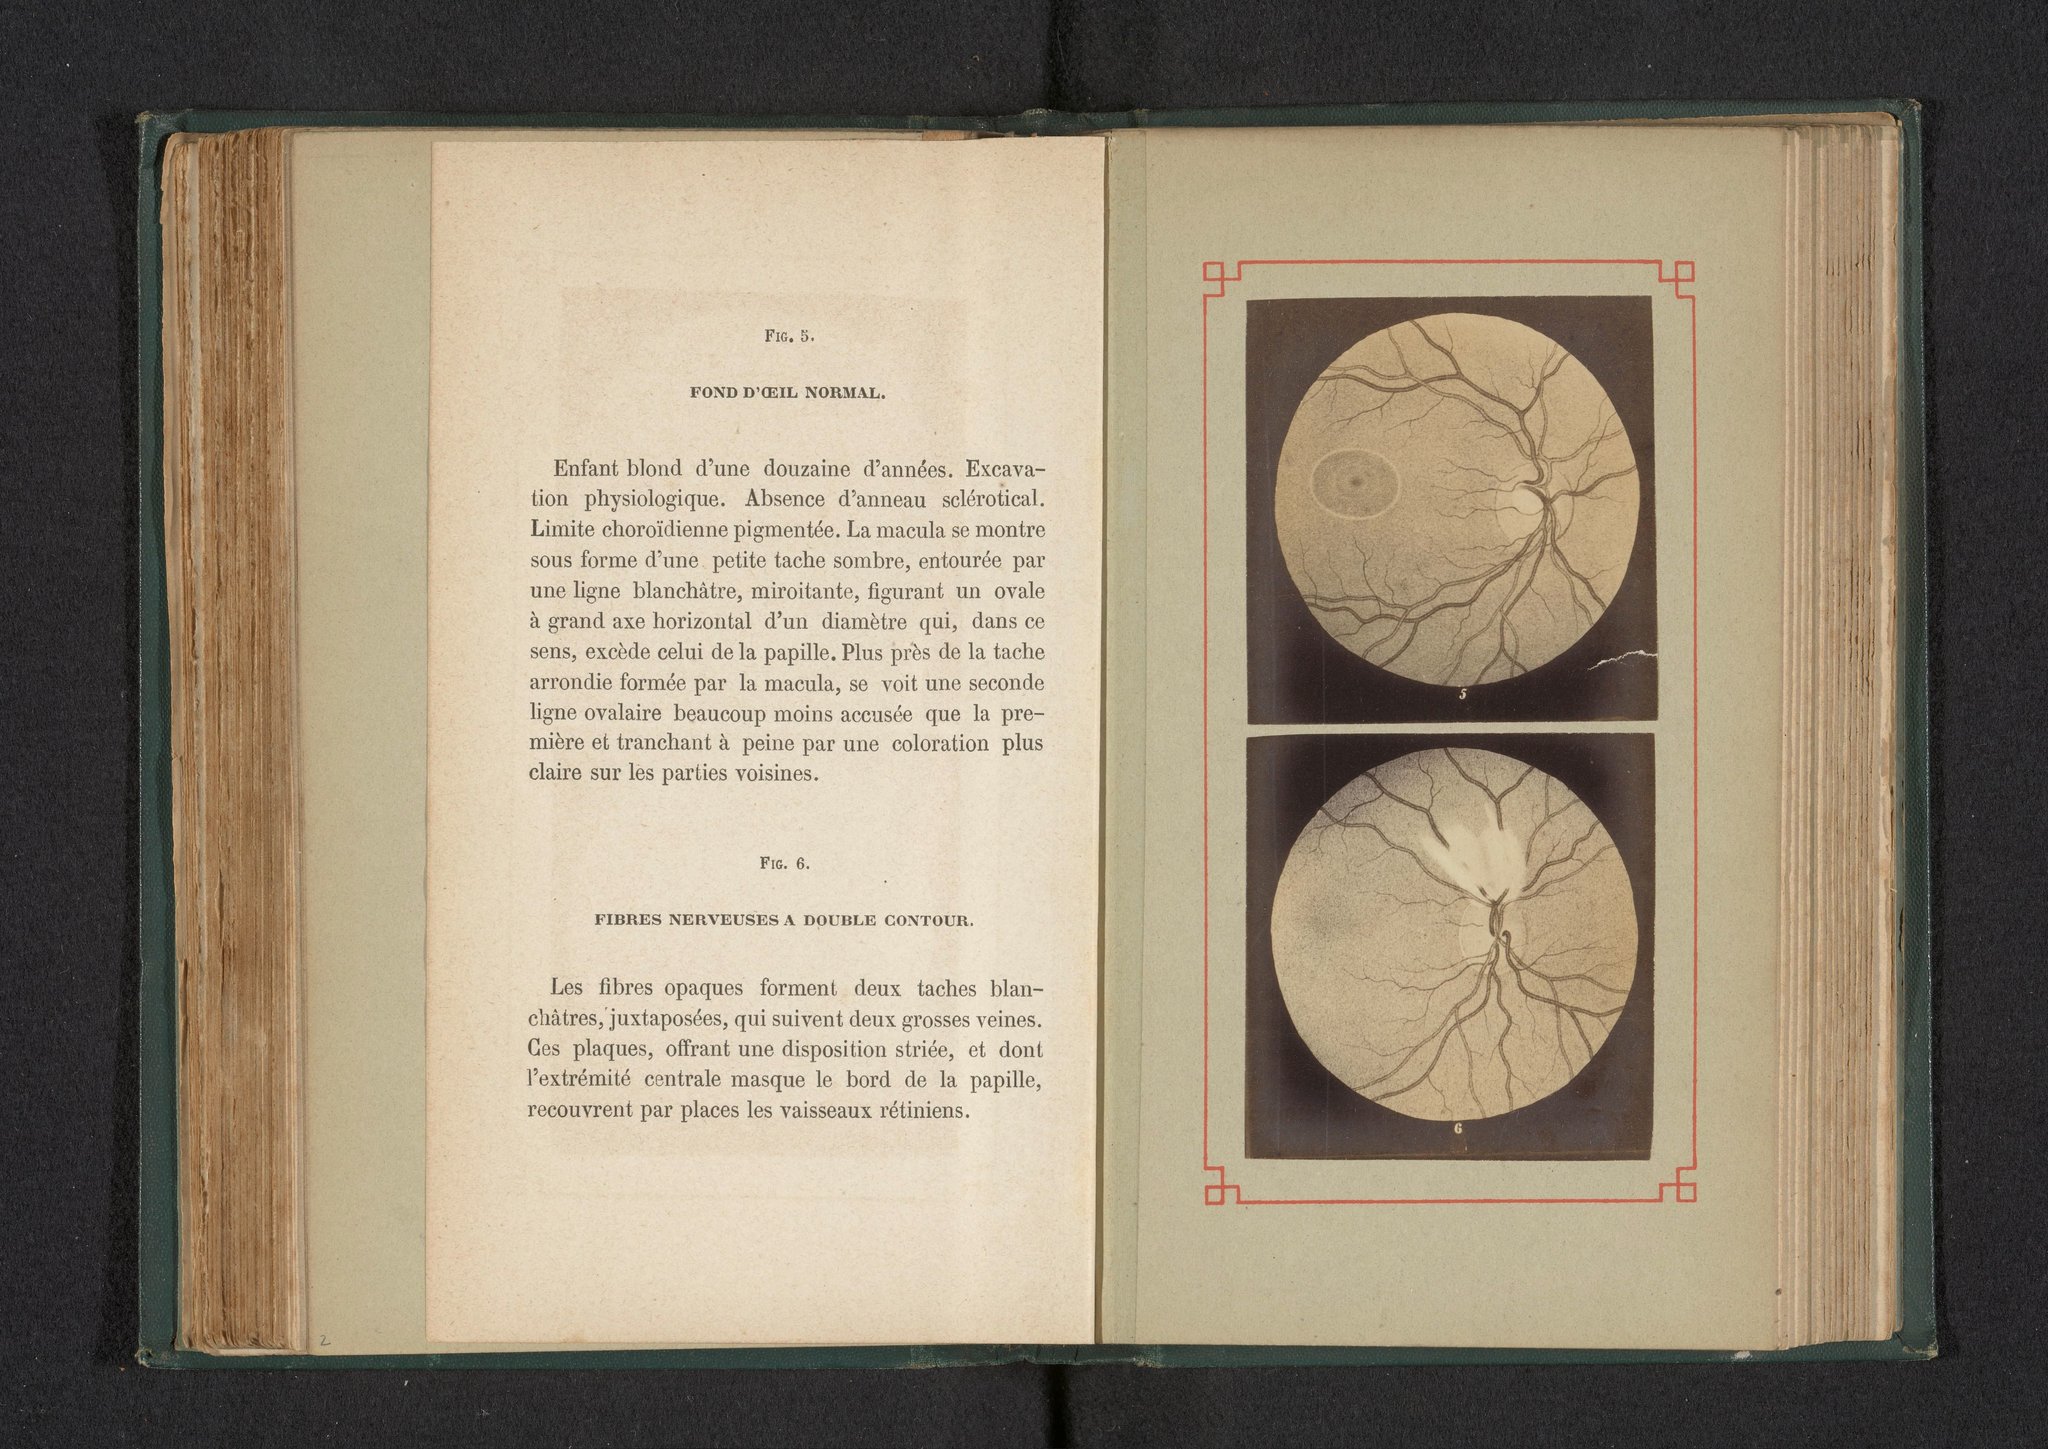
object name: photograph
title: Fotoreproductie van twee anatomische tekeningen van een normaal oog en de zenuwen in een oog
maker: Anonymous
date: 1871-1881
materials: photographic support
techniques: albumen print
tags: anatomy (non-medical), eyes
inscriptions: inscription: ‘Fig. 5. Fond d'oeil normal. Fig. 6. Fibres nerveuses a double contour.’